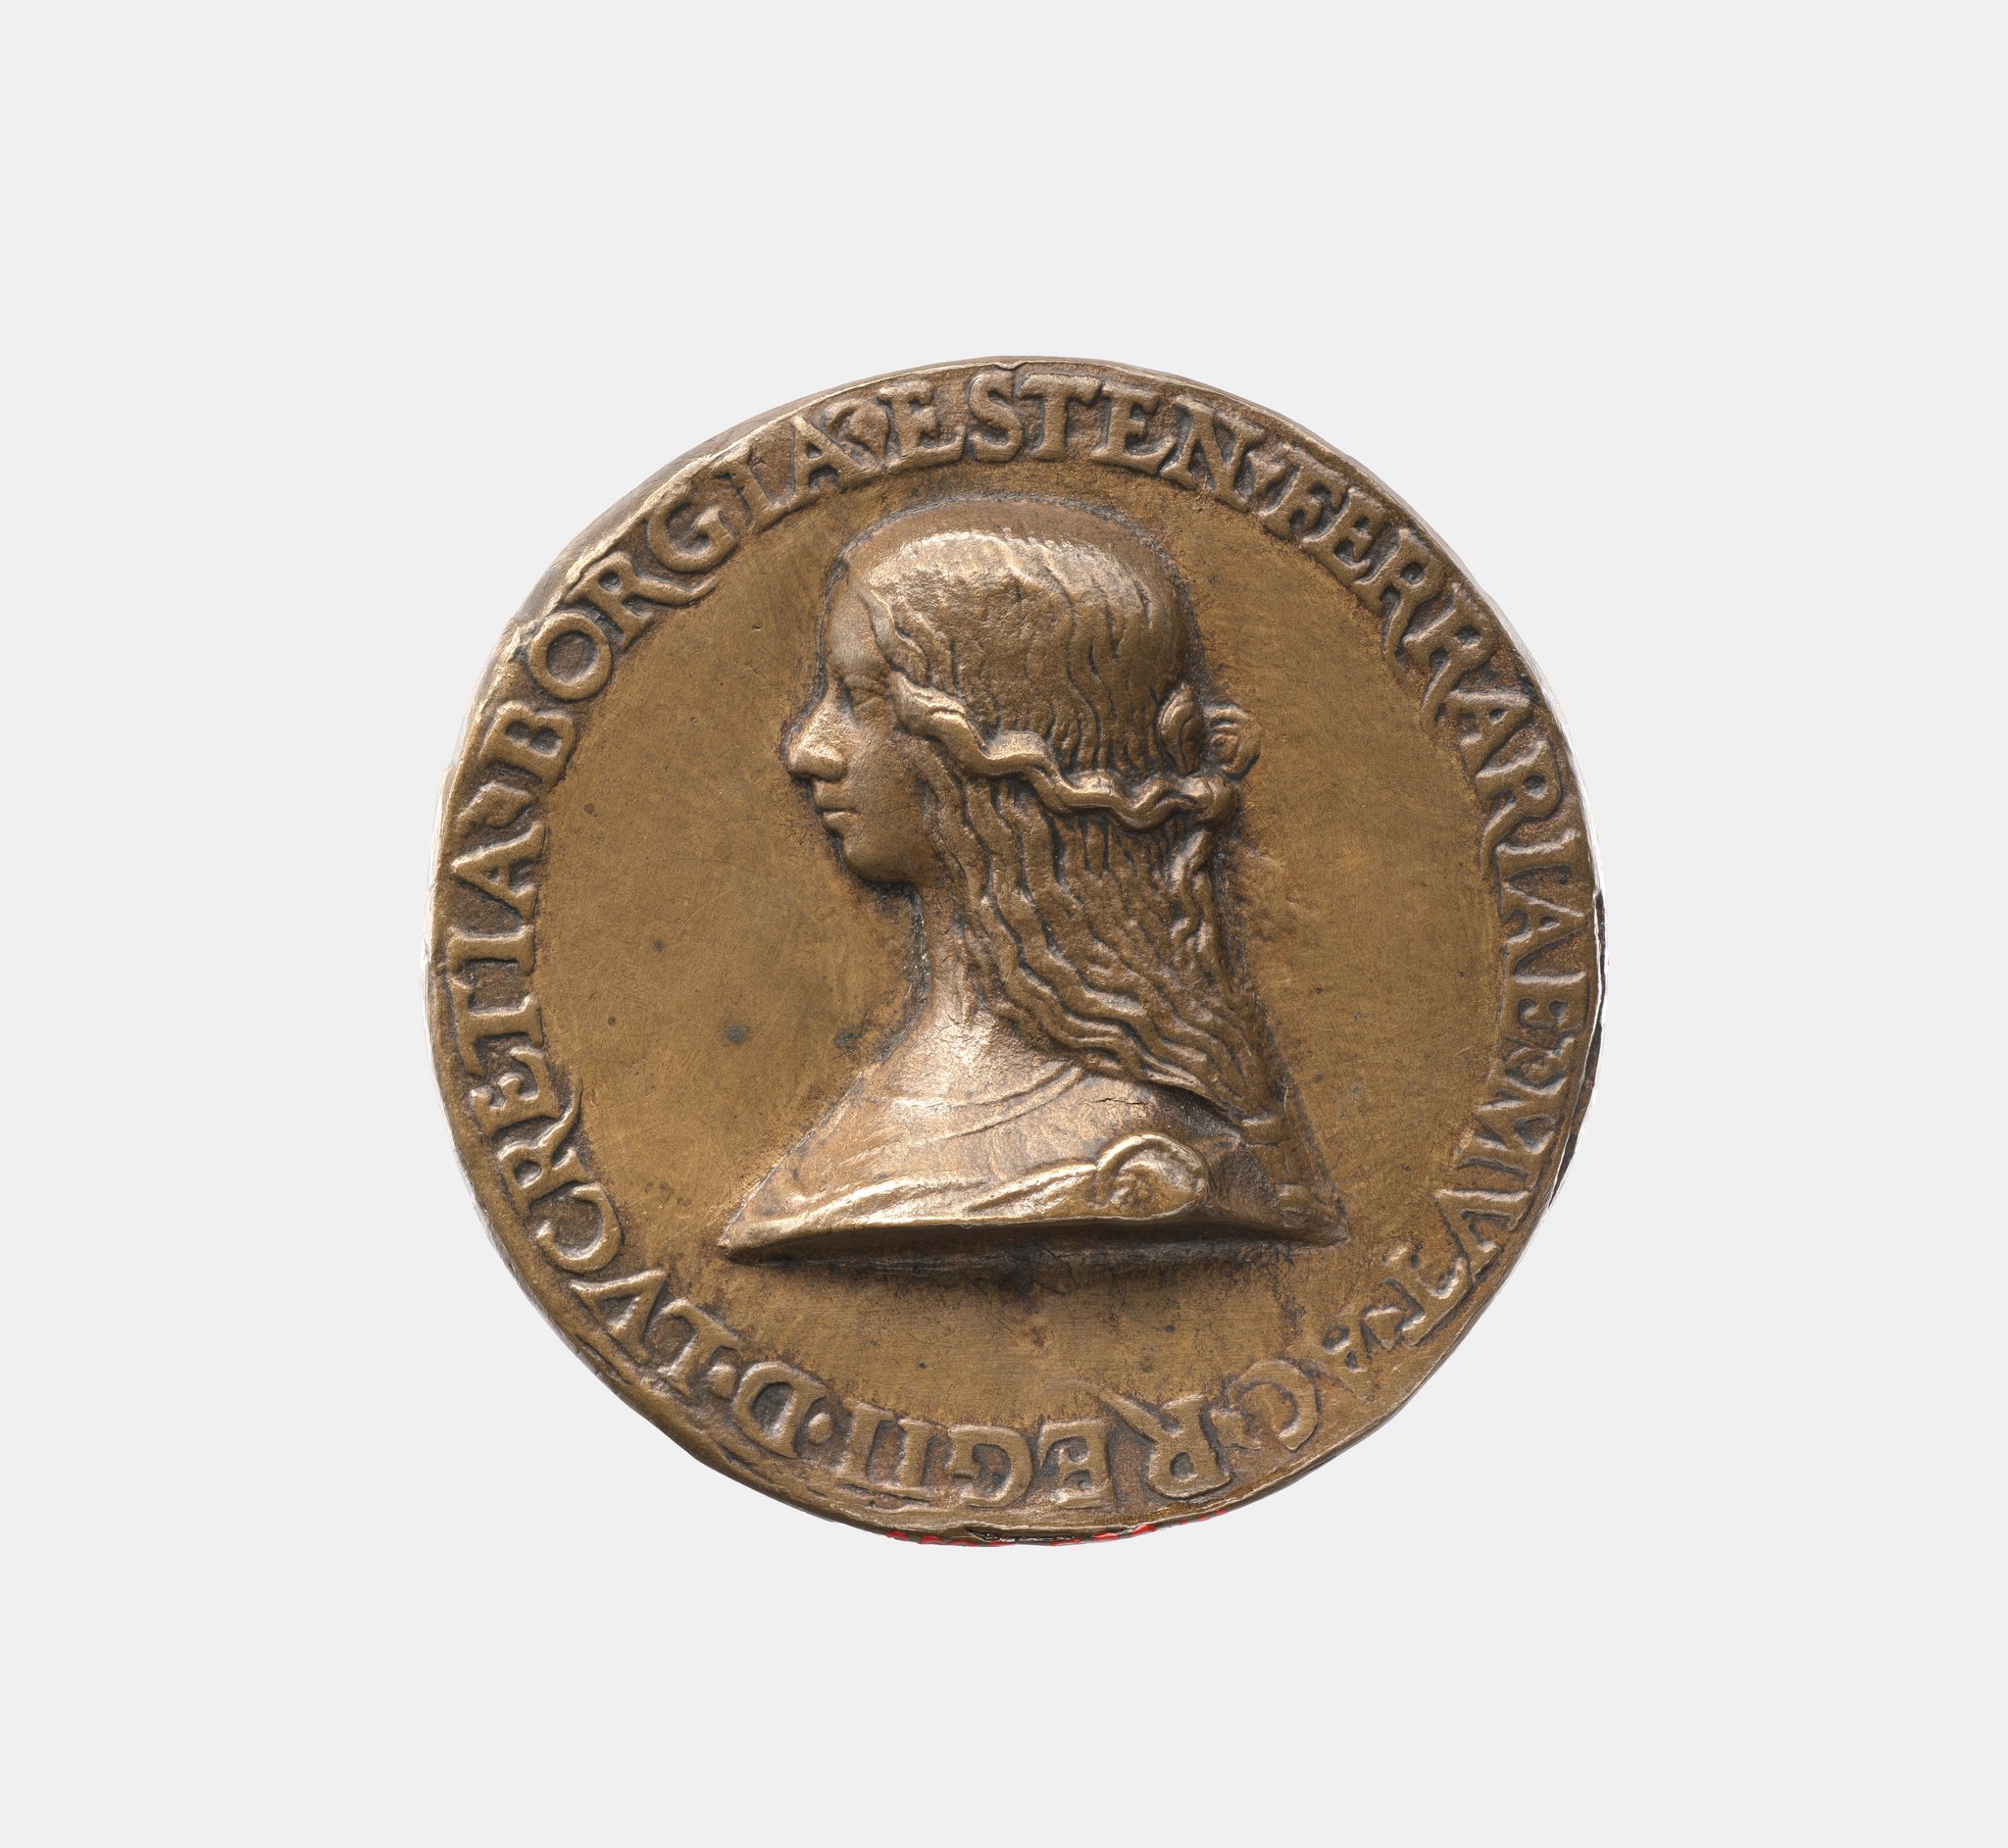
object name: medal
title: Lucrezia Borgia 1480-1519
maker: Anonymous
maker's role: artist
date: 1505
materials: bronze